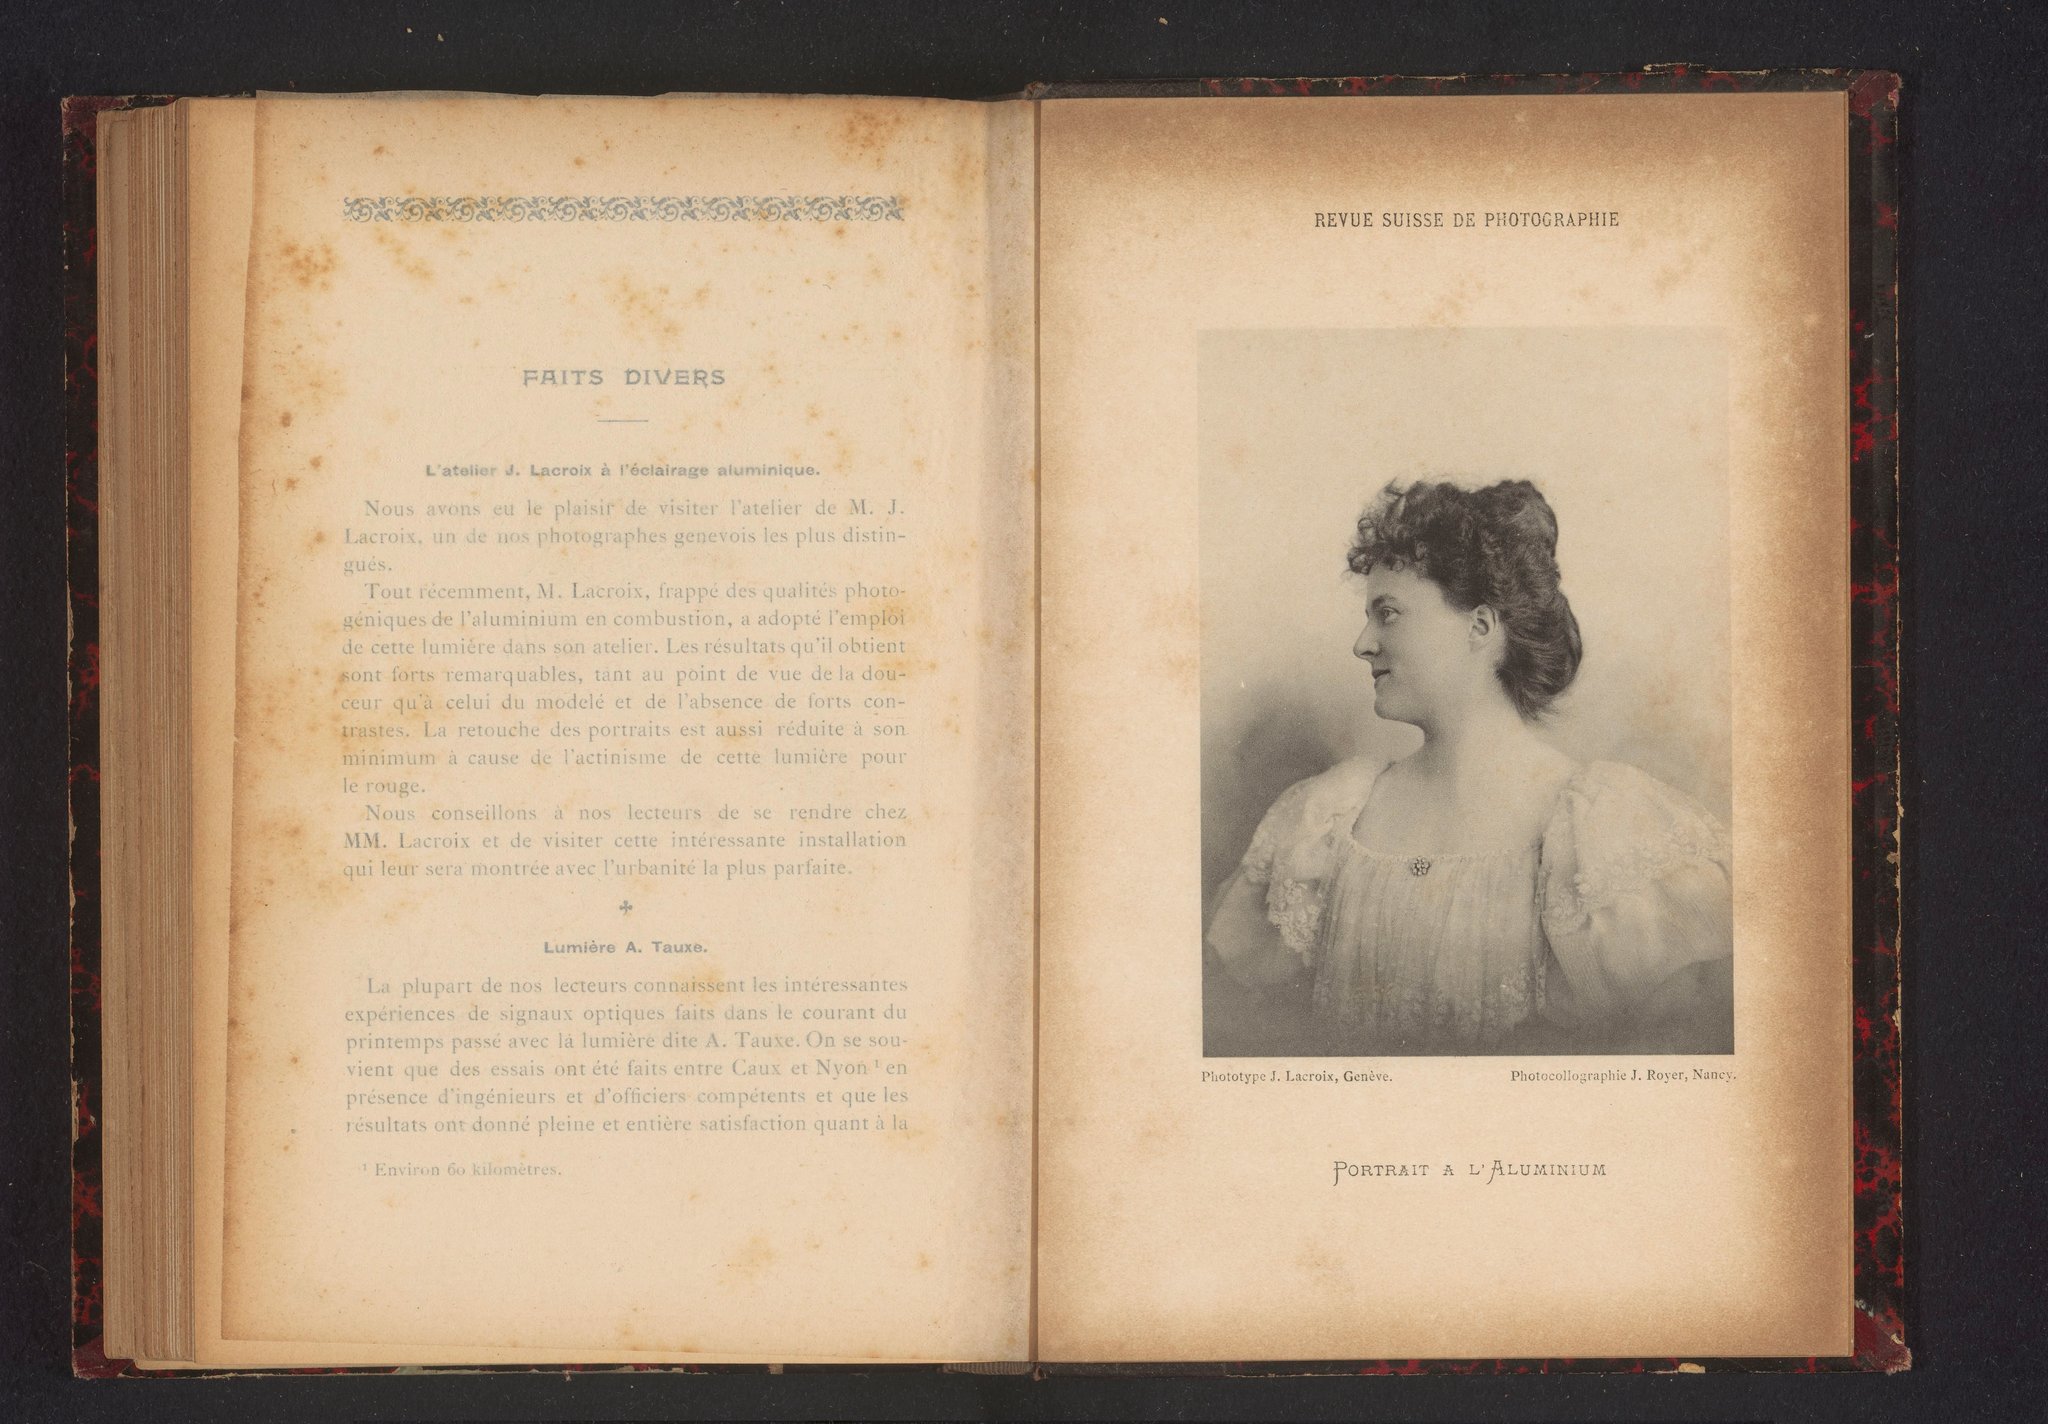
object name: page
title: Portret van een onbekende vrouw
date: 1892-1897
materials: paper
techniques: photograph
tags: historical persons not known by name - bb - woman